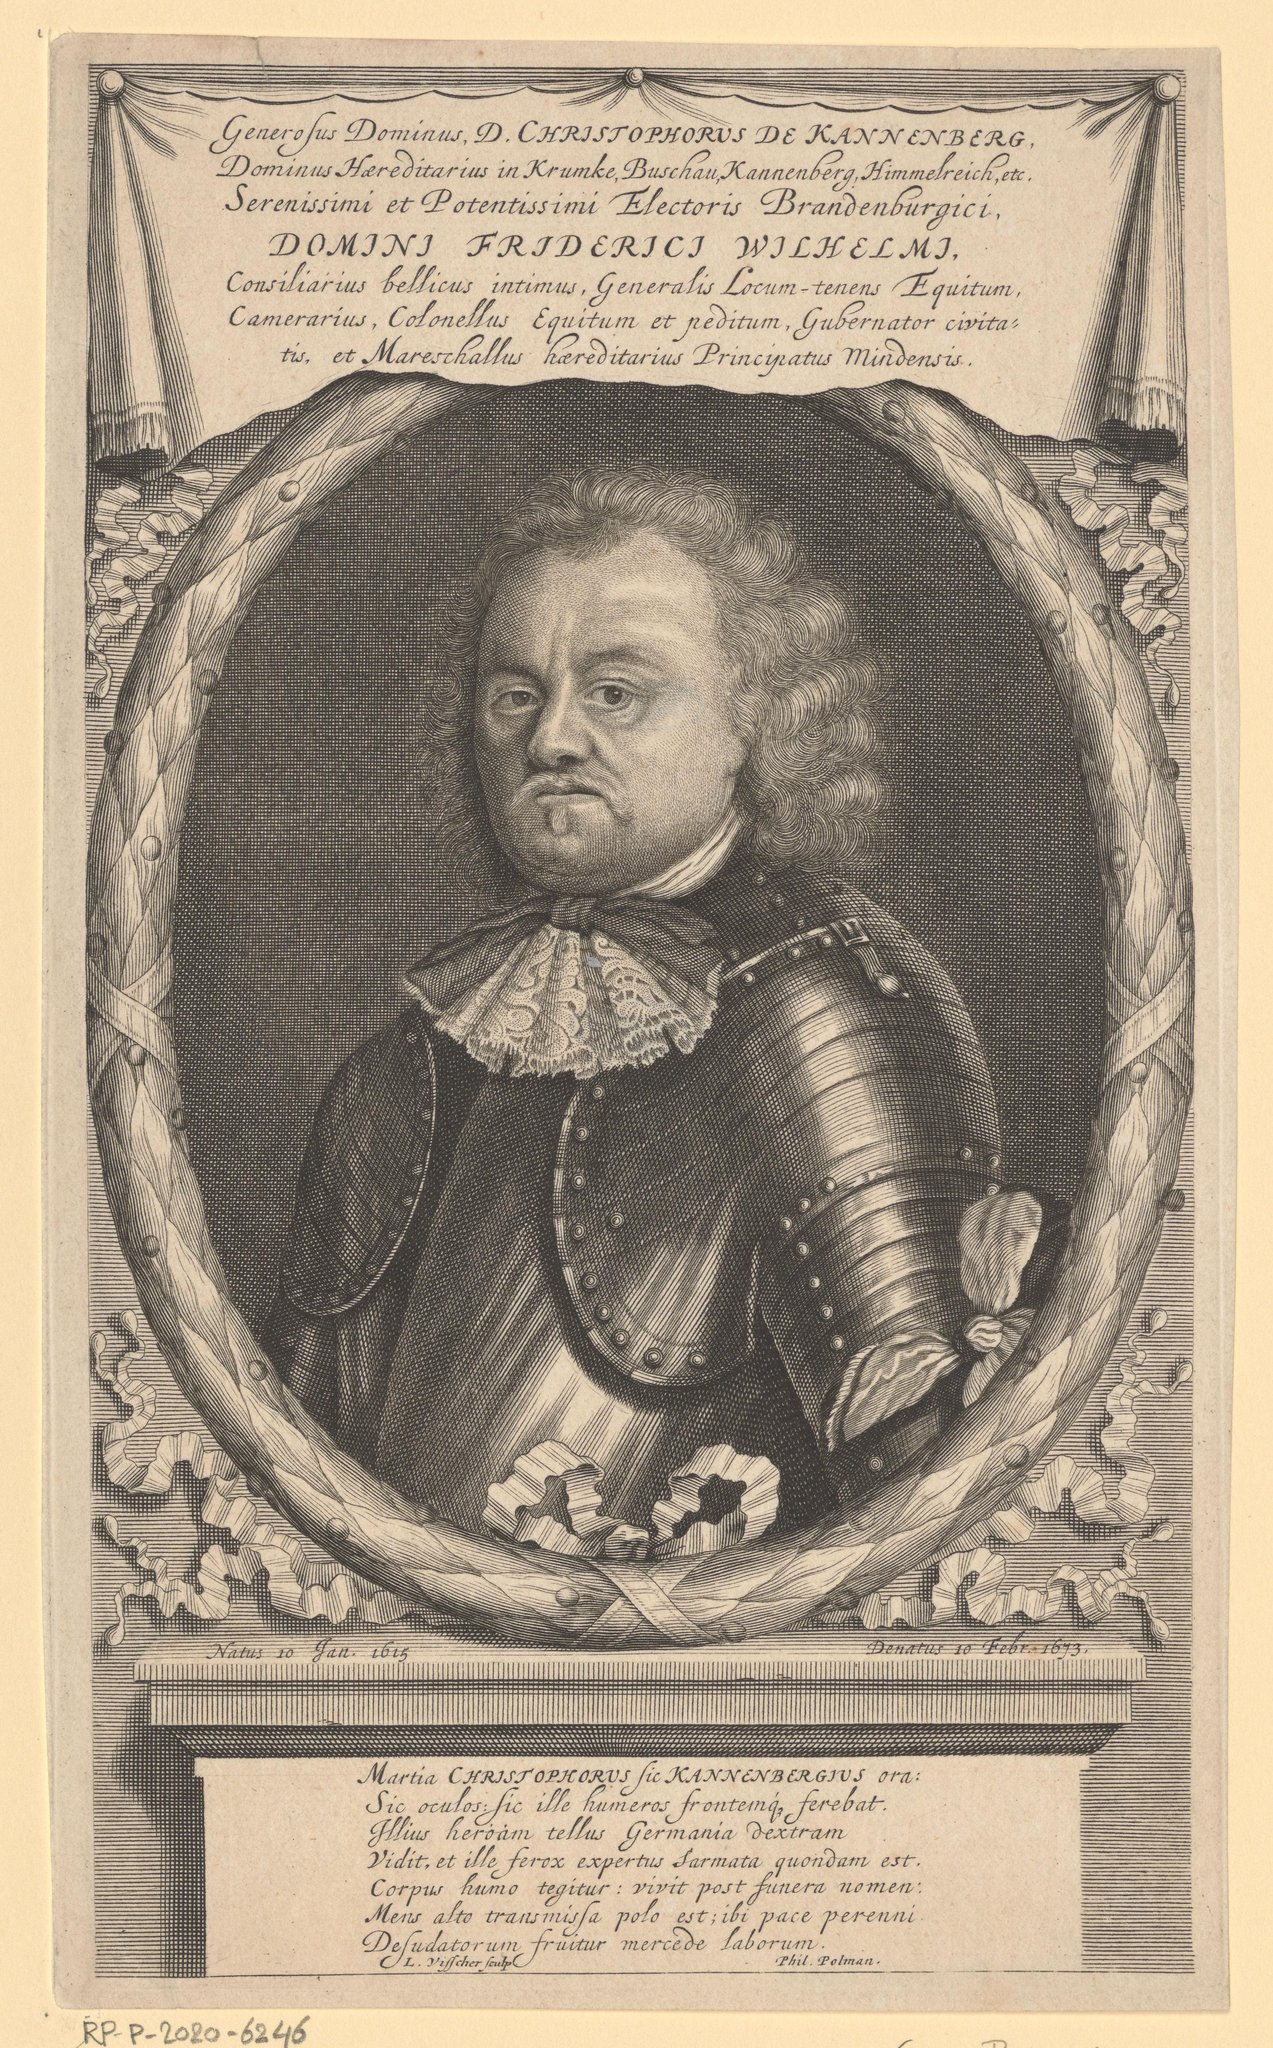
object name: print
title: Portret van Christoph von Kannenberg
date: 1673-1690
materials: paper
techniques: engraving, etching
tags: historical persons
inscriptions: collector's mark: Lugt 2228